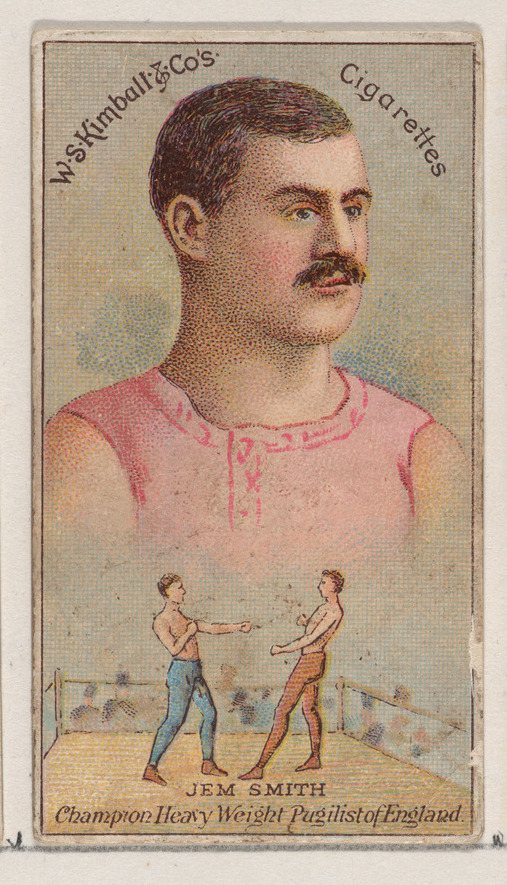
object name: print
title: Jem Smith, Heavy Weight Pugilist of England, from the Champions of Games and Sports series (N184, Type 1) issued by W.S. Kimball & Co.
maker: w.s. kimball & co.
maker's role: publisher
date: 1887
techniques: color lithograph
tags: men,boxing,athletes